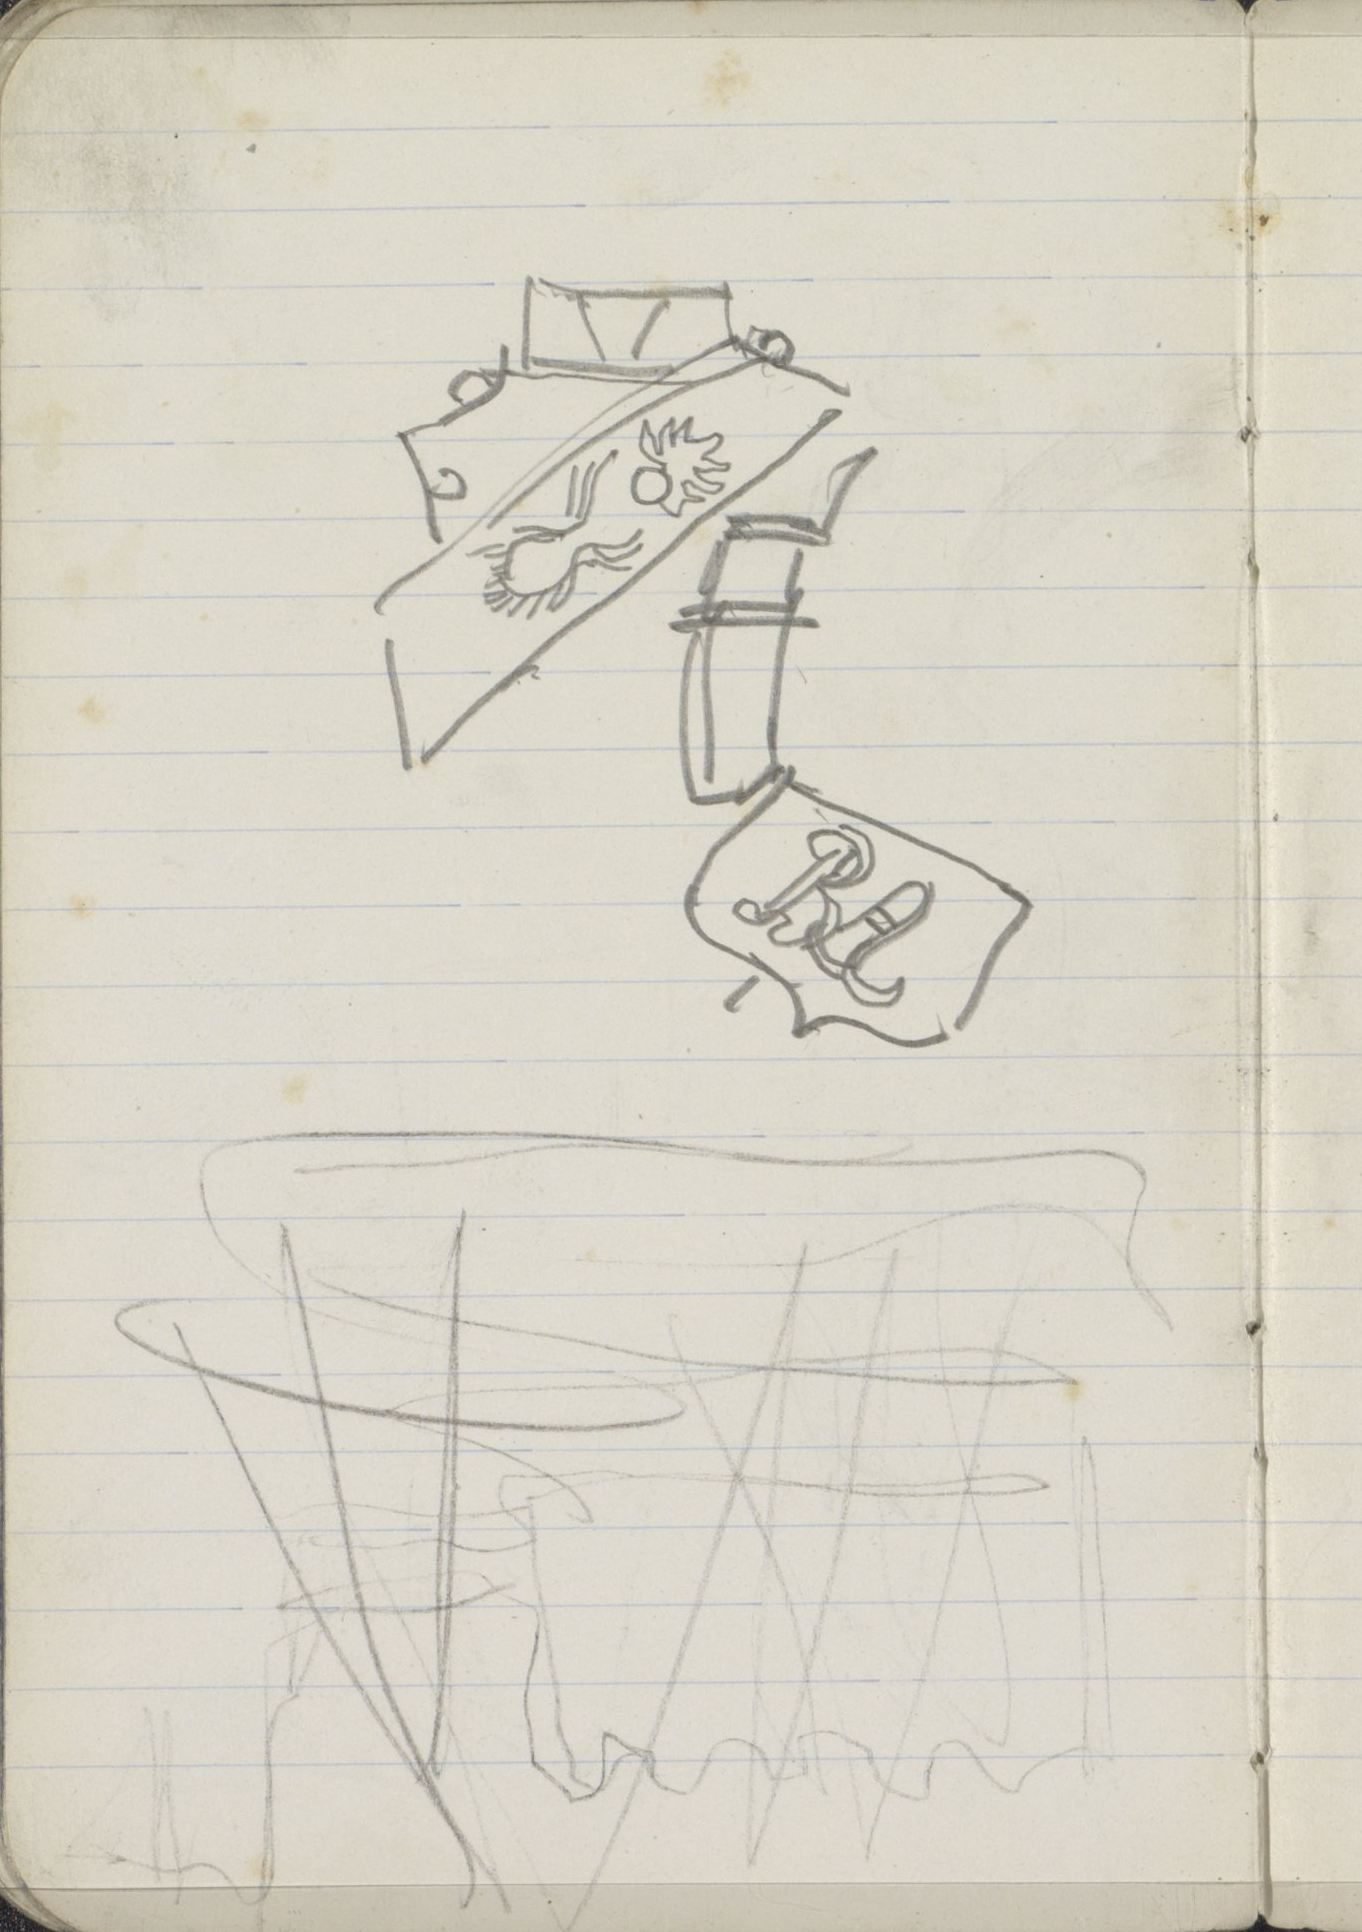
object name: sketchbook leaf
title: Studies, mogelijk van kostuum- of wapendecoraties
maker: george hendrik breitner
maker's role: draughtsman, painter, print maker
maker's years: 1857-1923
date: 1898-1902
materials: pencil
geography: amsterdam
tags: accessories (~ clothing)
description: Verder een gezicht in Amsterdam. Pagina 75 uit een schetsboek met 42 bladen.